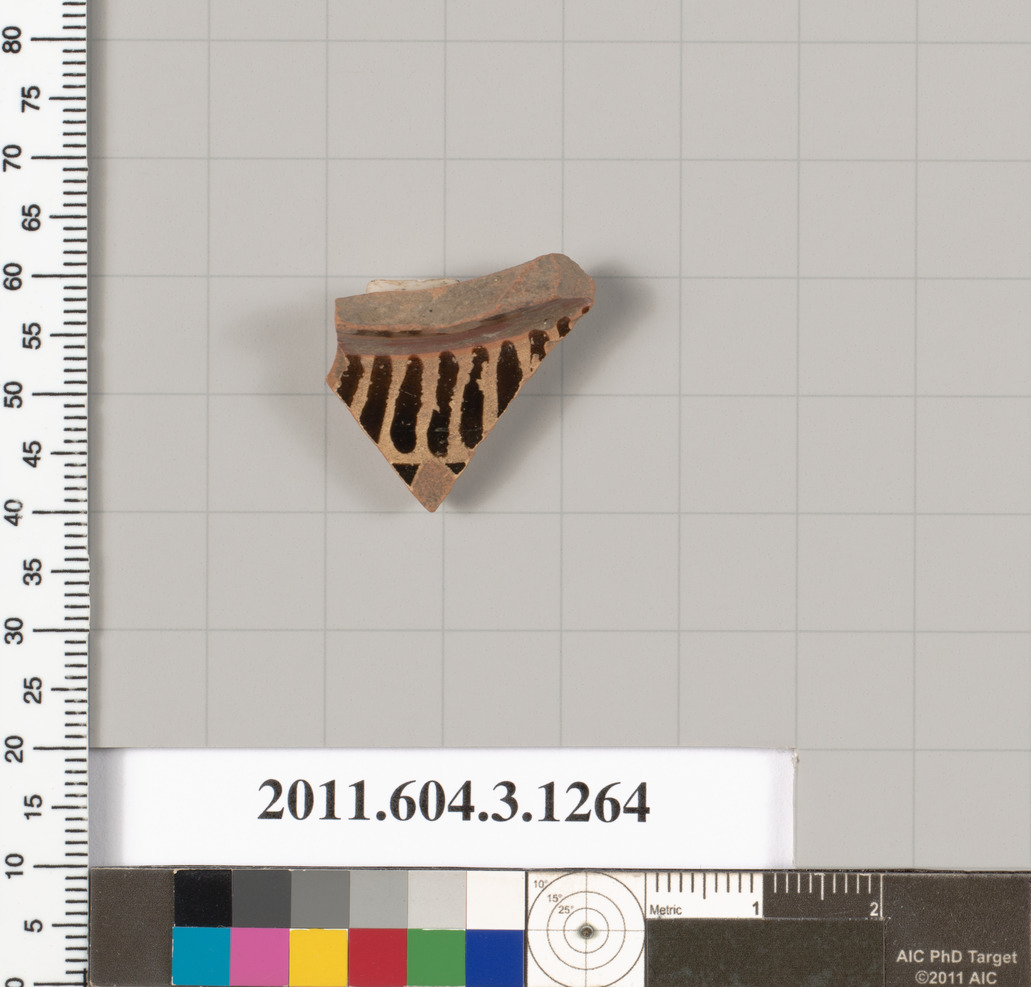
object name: oinochoe fragment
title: Terracotta fragment of an oinochoe (jug)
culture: greek, attic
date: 534-468 BCE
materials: terracotta